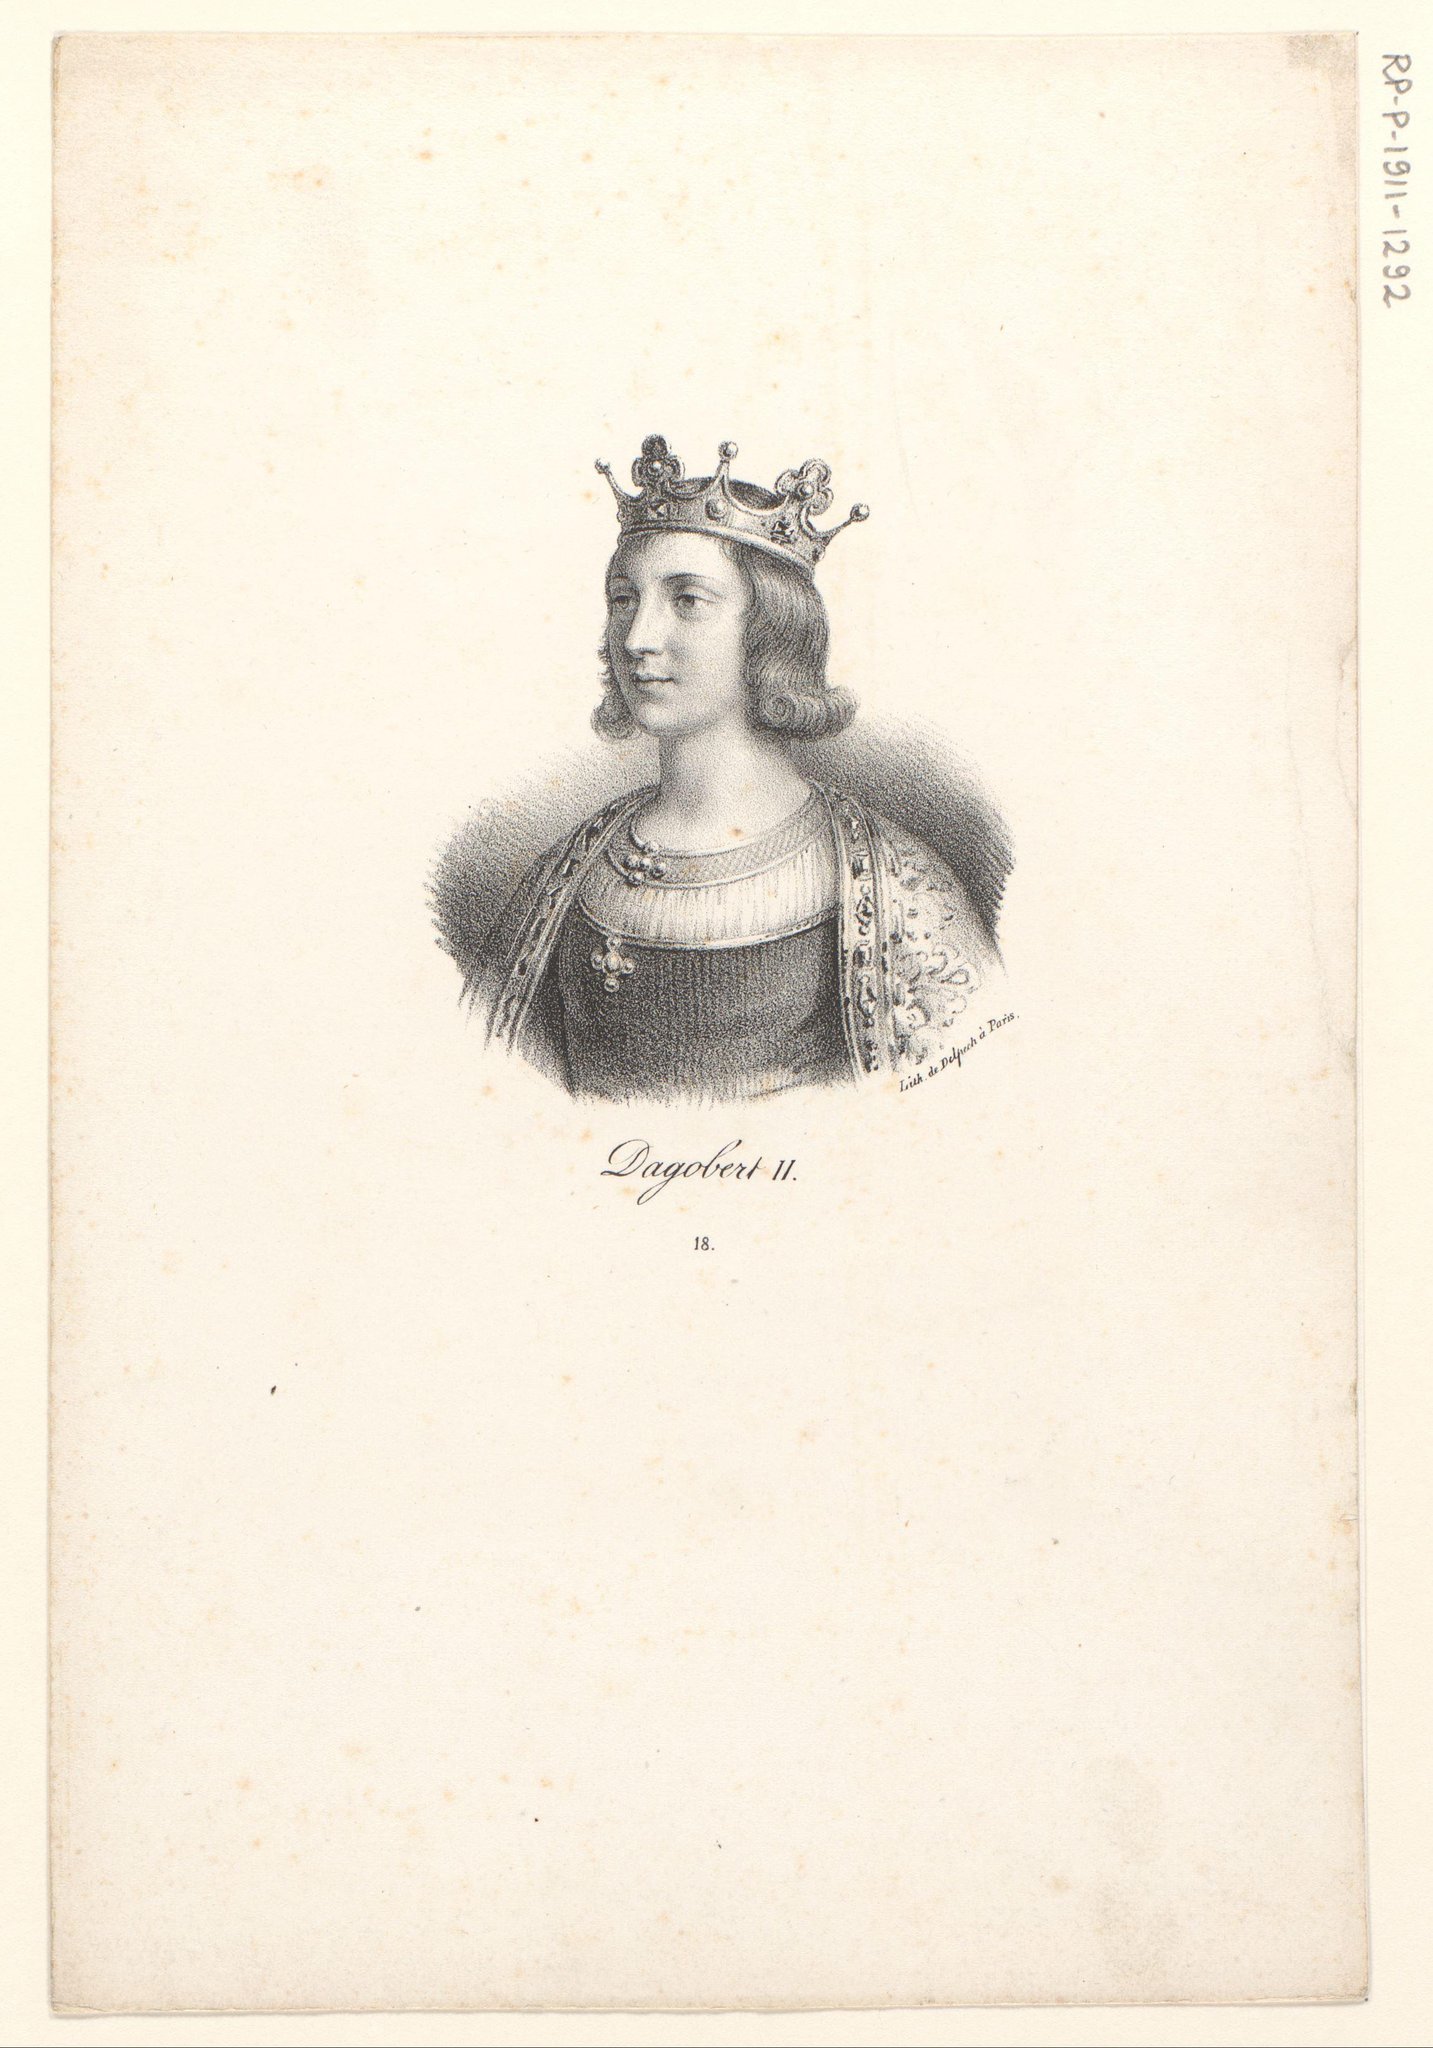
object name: print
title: Portret van koning Dagobert II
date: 1818-1842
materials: paper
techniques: lithograph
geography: paris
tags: historical persons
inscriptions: collector's mark: Lugt 2228a